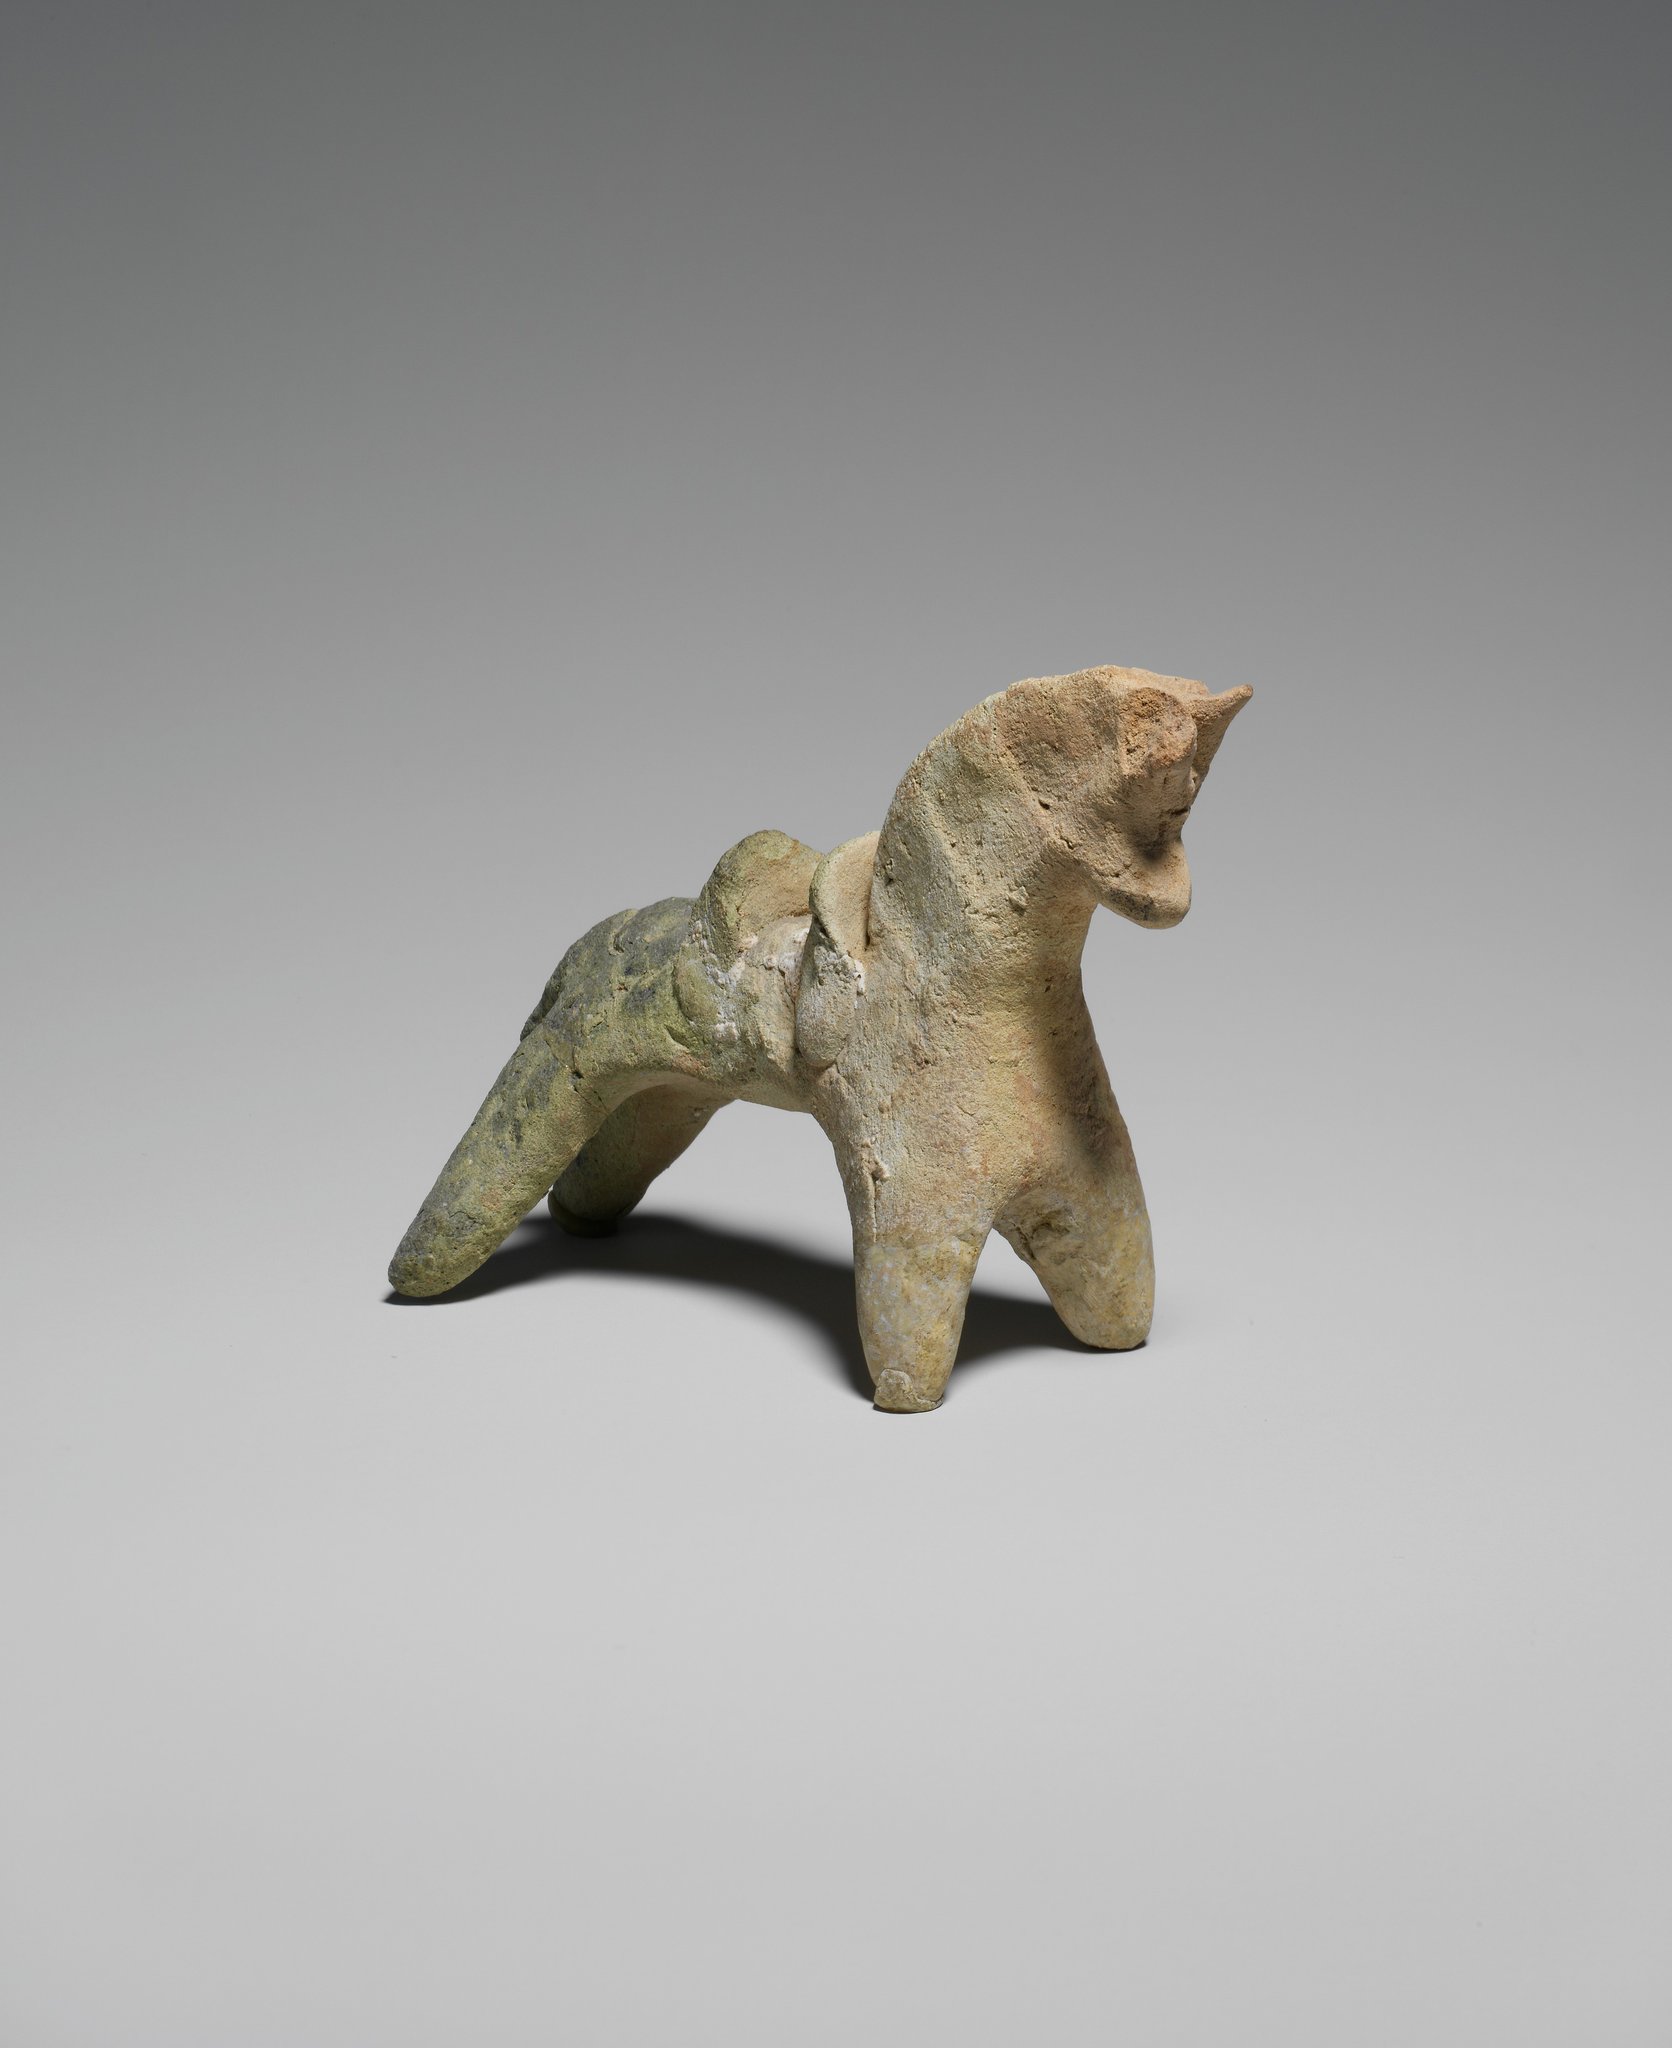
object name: figure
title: Horse Figurine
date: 801-900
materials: earthenware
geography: iran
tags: horses,toys